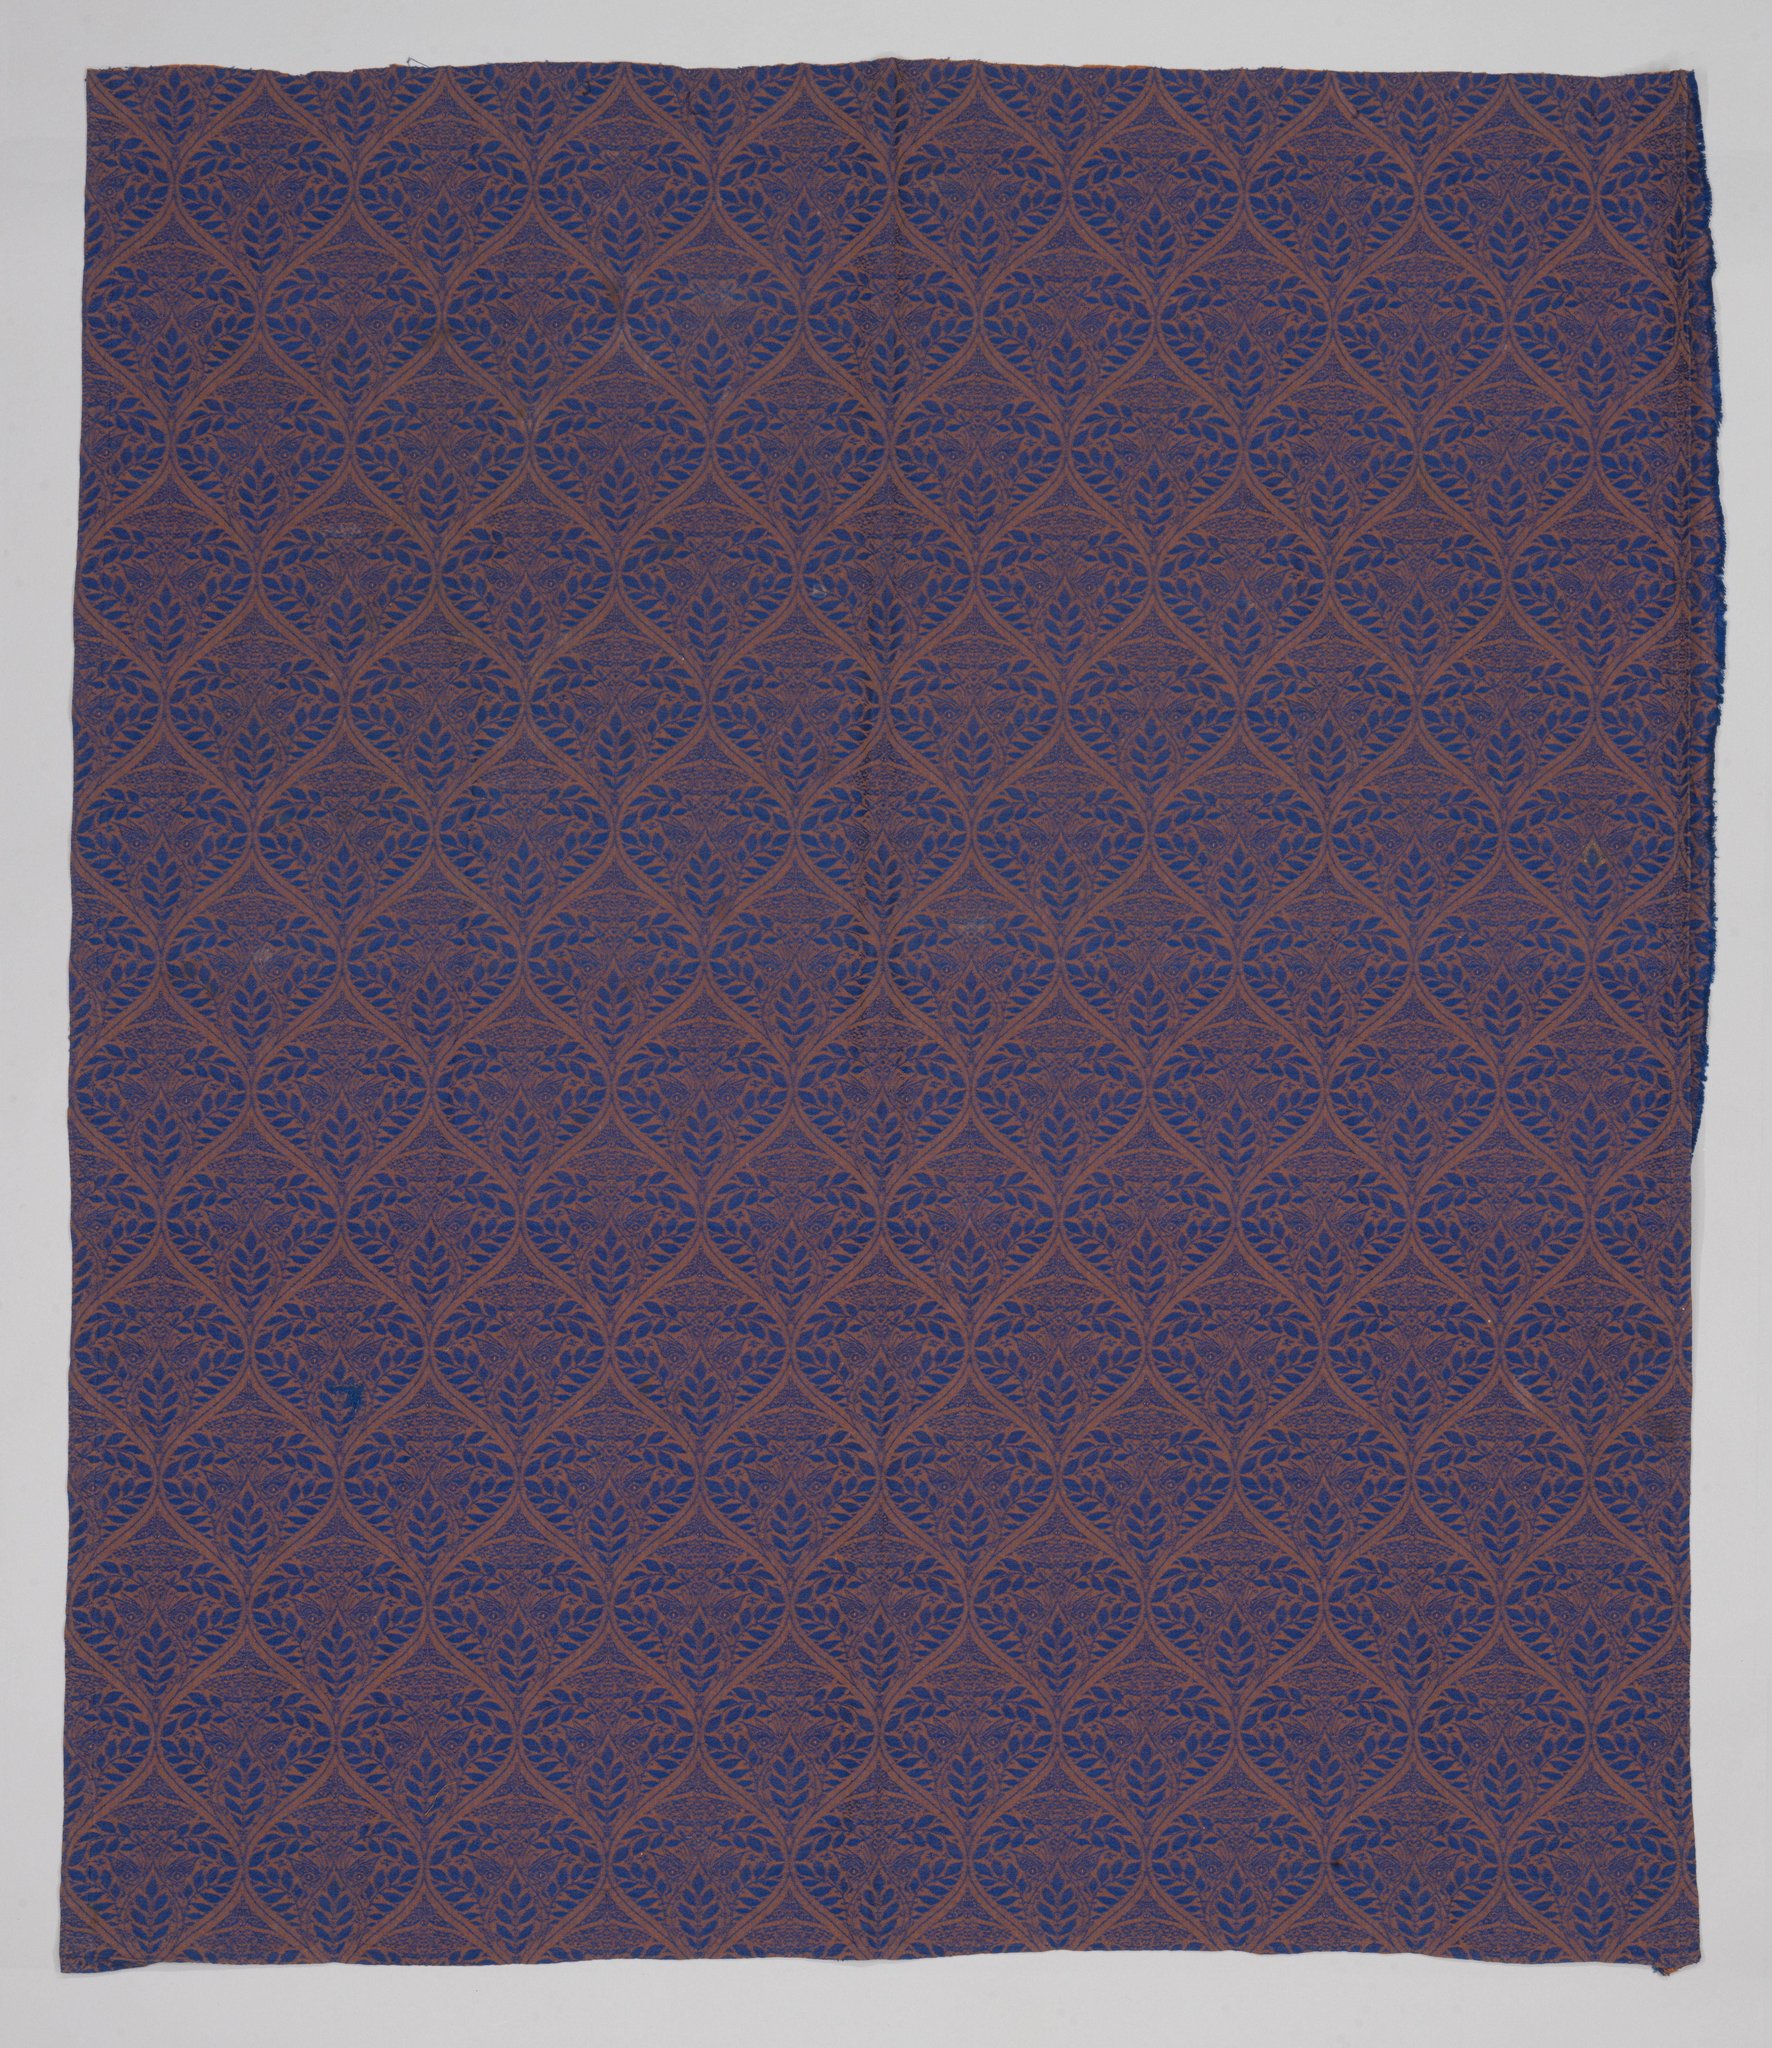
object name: upholstery fabric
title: Fragment gordijn- of bespanningsstof met patroon van bladeren, bloemen, vlinders en kevers binnen spitsovalen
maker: theo nieuwenhuis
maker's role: designer, draughtsman, print maker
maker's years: 1866-1951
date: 1900-1925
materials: cotton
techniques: jacquard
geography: netherlands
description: Fragment gordijn- of bespanningsstof met patroon van bladeren, bloemen, vlinders en kevers binnen spitsovalen. Blauwe inslag op groene ketting.